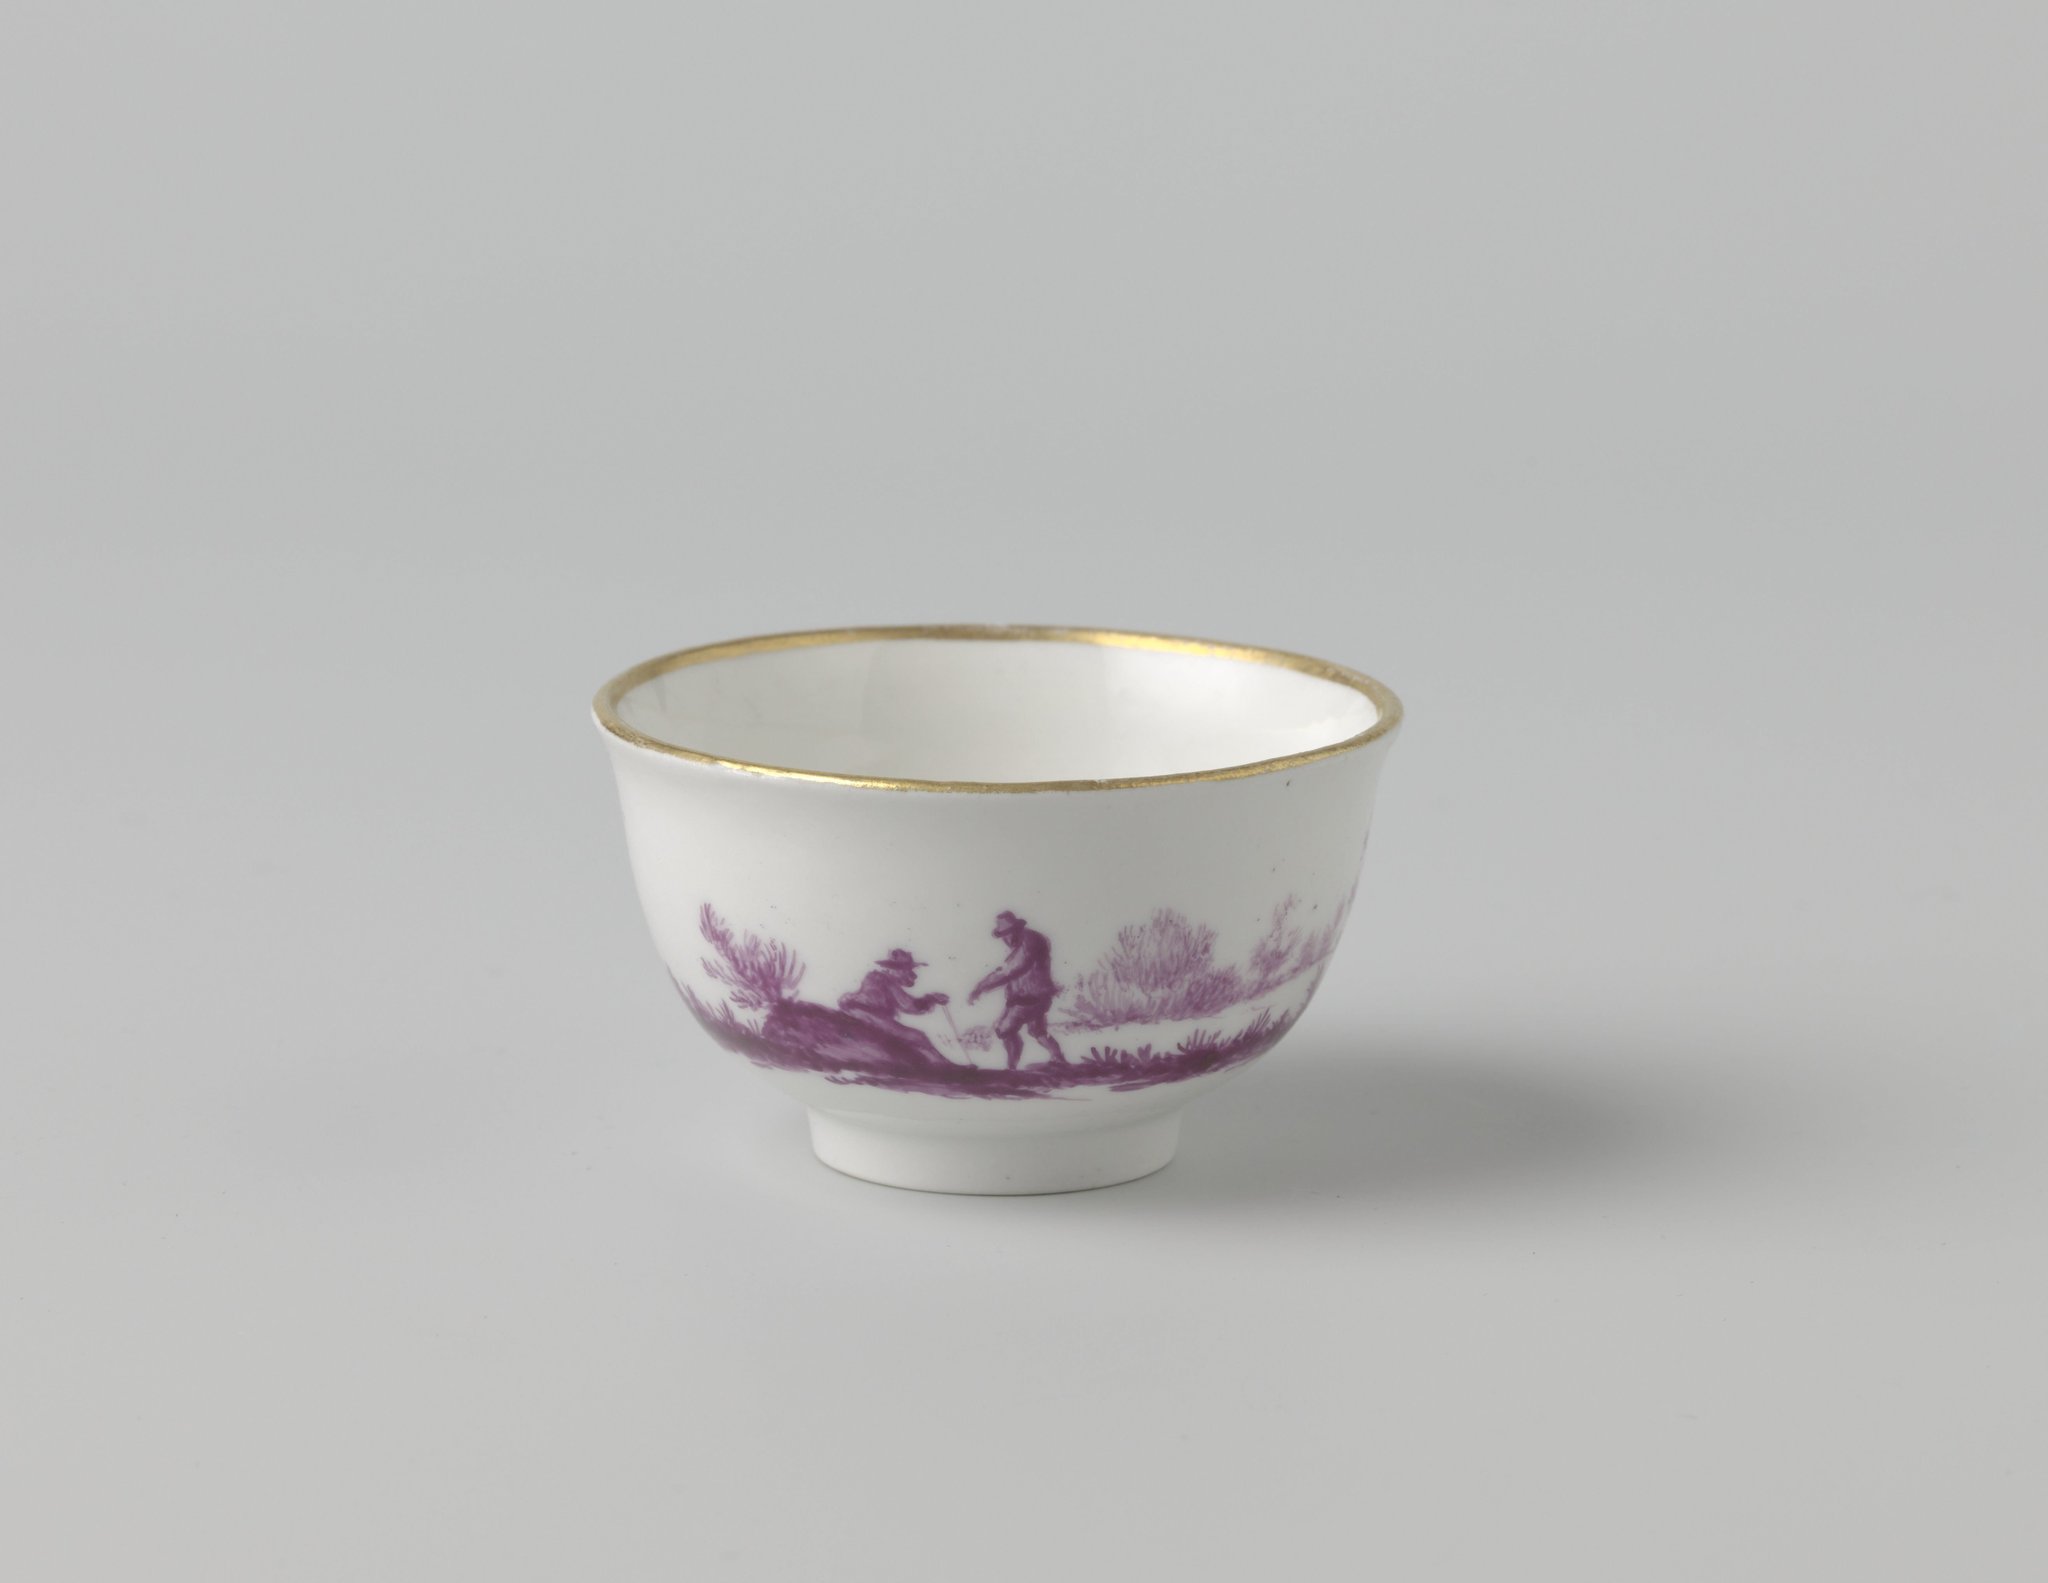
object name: tea cup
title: Theekop met figuren in landschap in bietenrood met gouden biezen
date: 1775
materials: porcelain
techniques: painted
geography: loosdrecht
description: Theekop van porselein, zonder oor. Beschilderd met figuren in een landschap in bietenrood en gouden biezen.